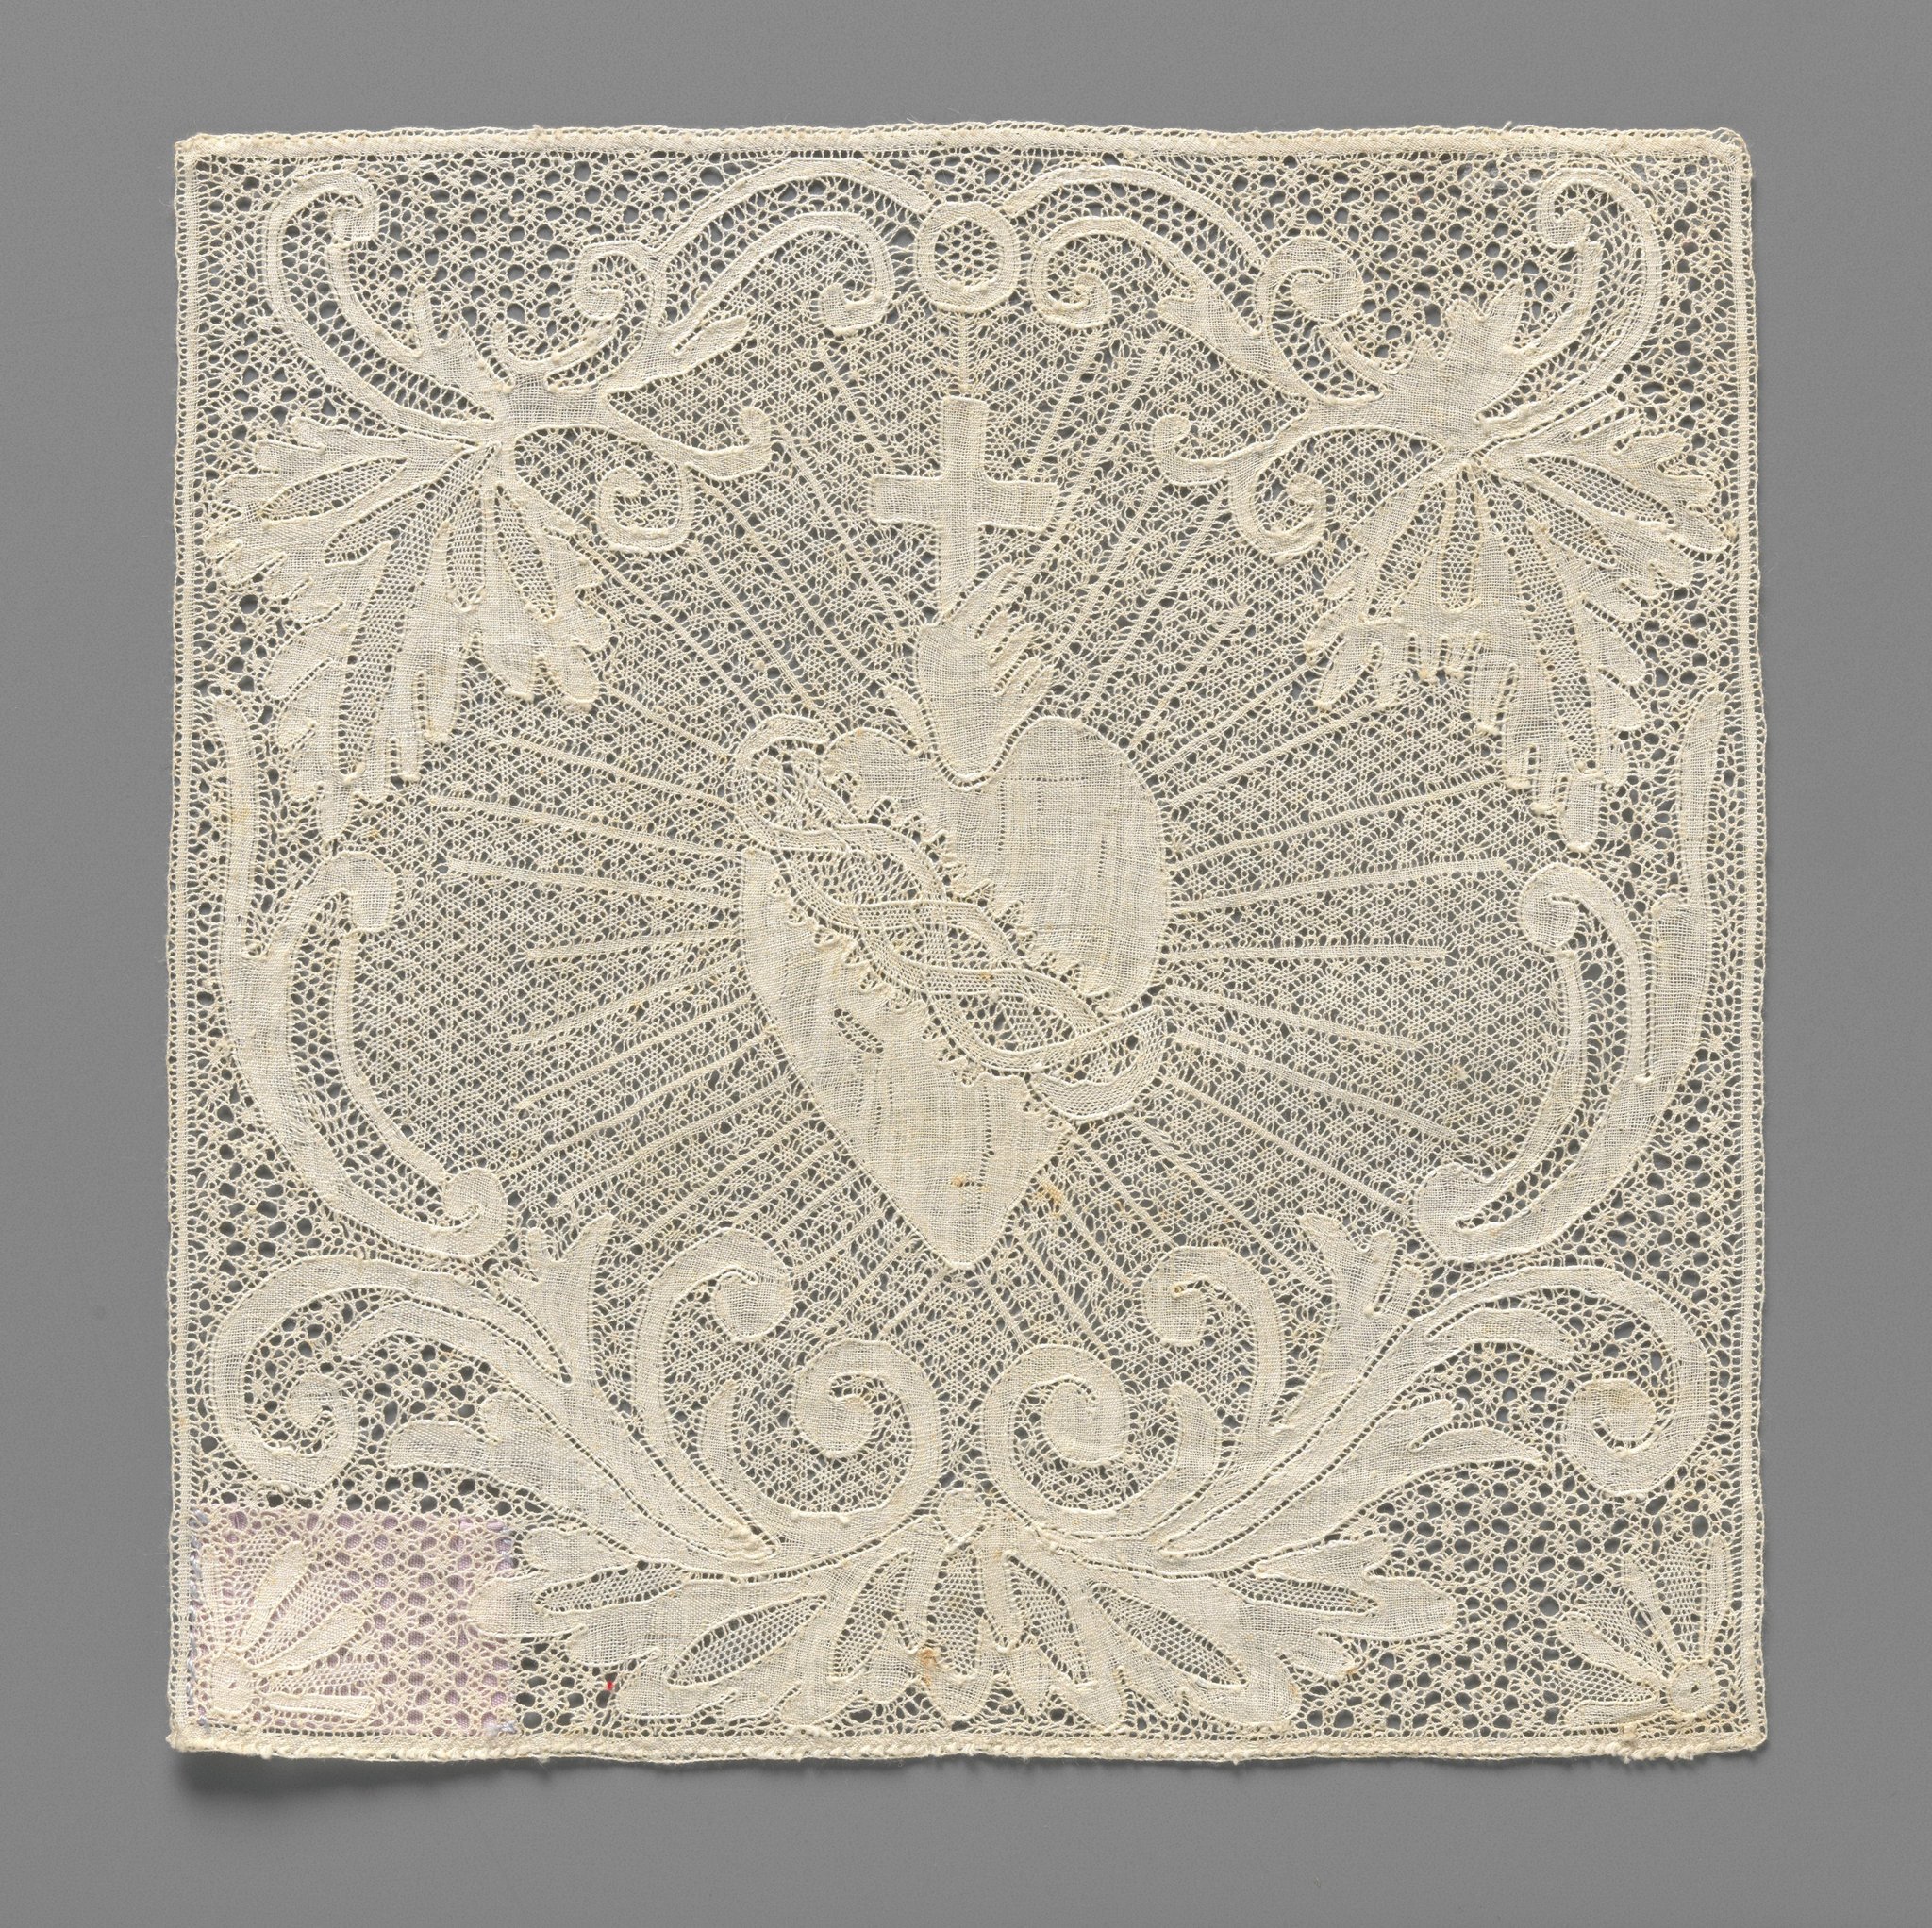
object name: palla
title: Palla van kloskant met het Heilige hart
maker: Anonymous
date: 1900-1999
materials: linen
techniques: lace, snowflake filling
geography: belgium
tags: the sacred heart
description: Palla van naturelkleurige kloskant: Mechelse kant met sneeuwvlokkengrond (ook wel Binche-grond genoemd). Vierkant model met in het centrum het Heilige Hart motief.